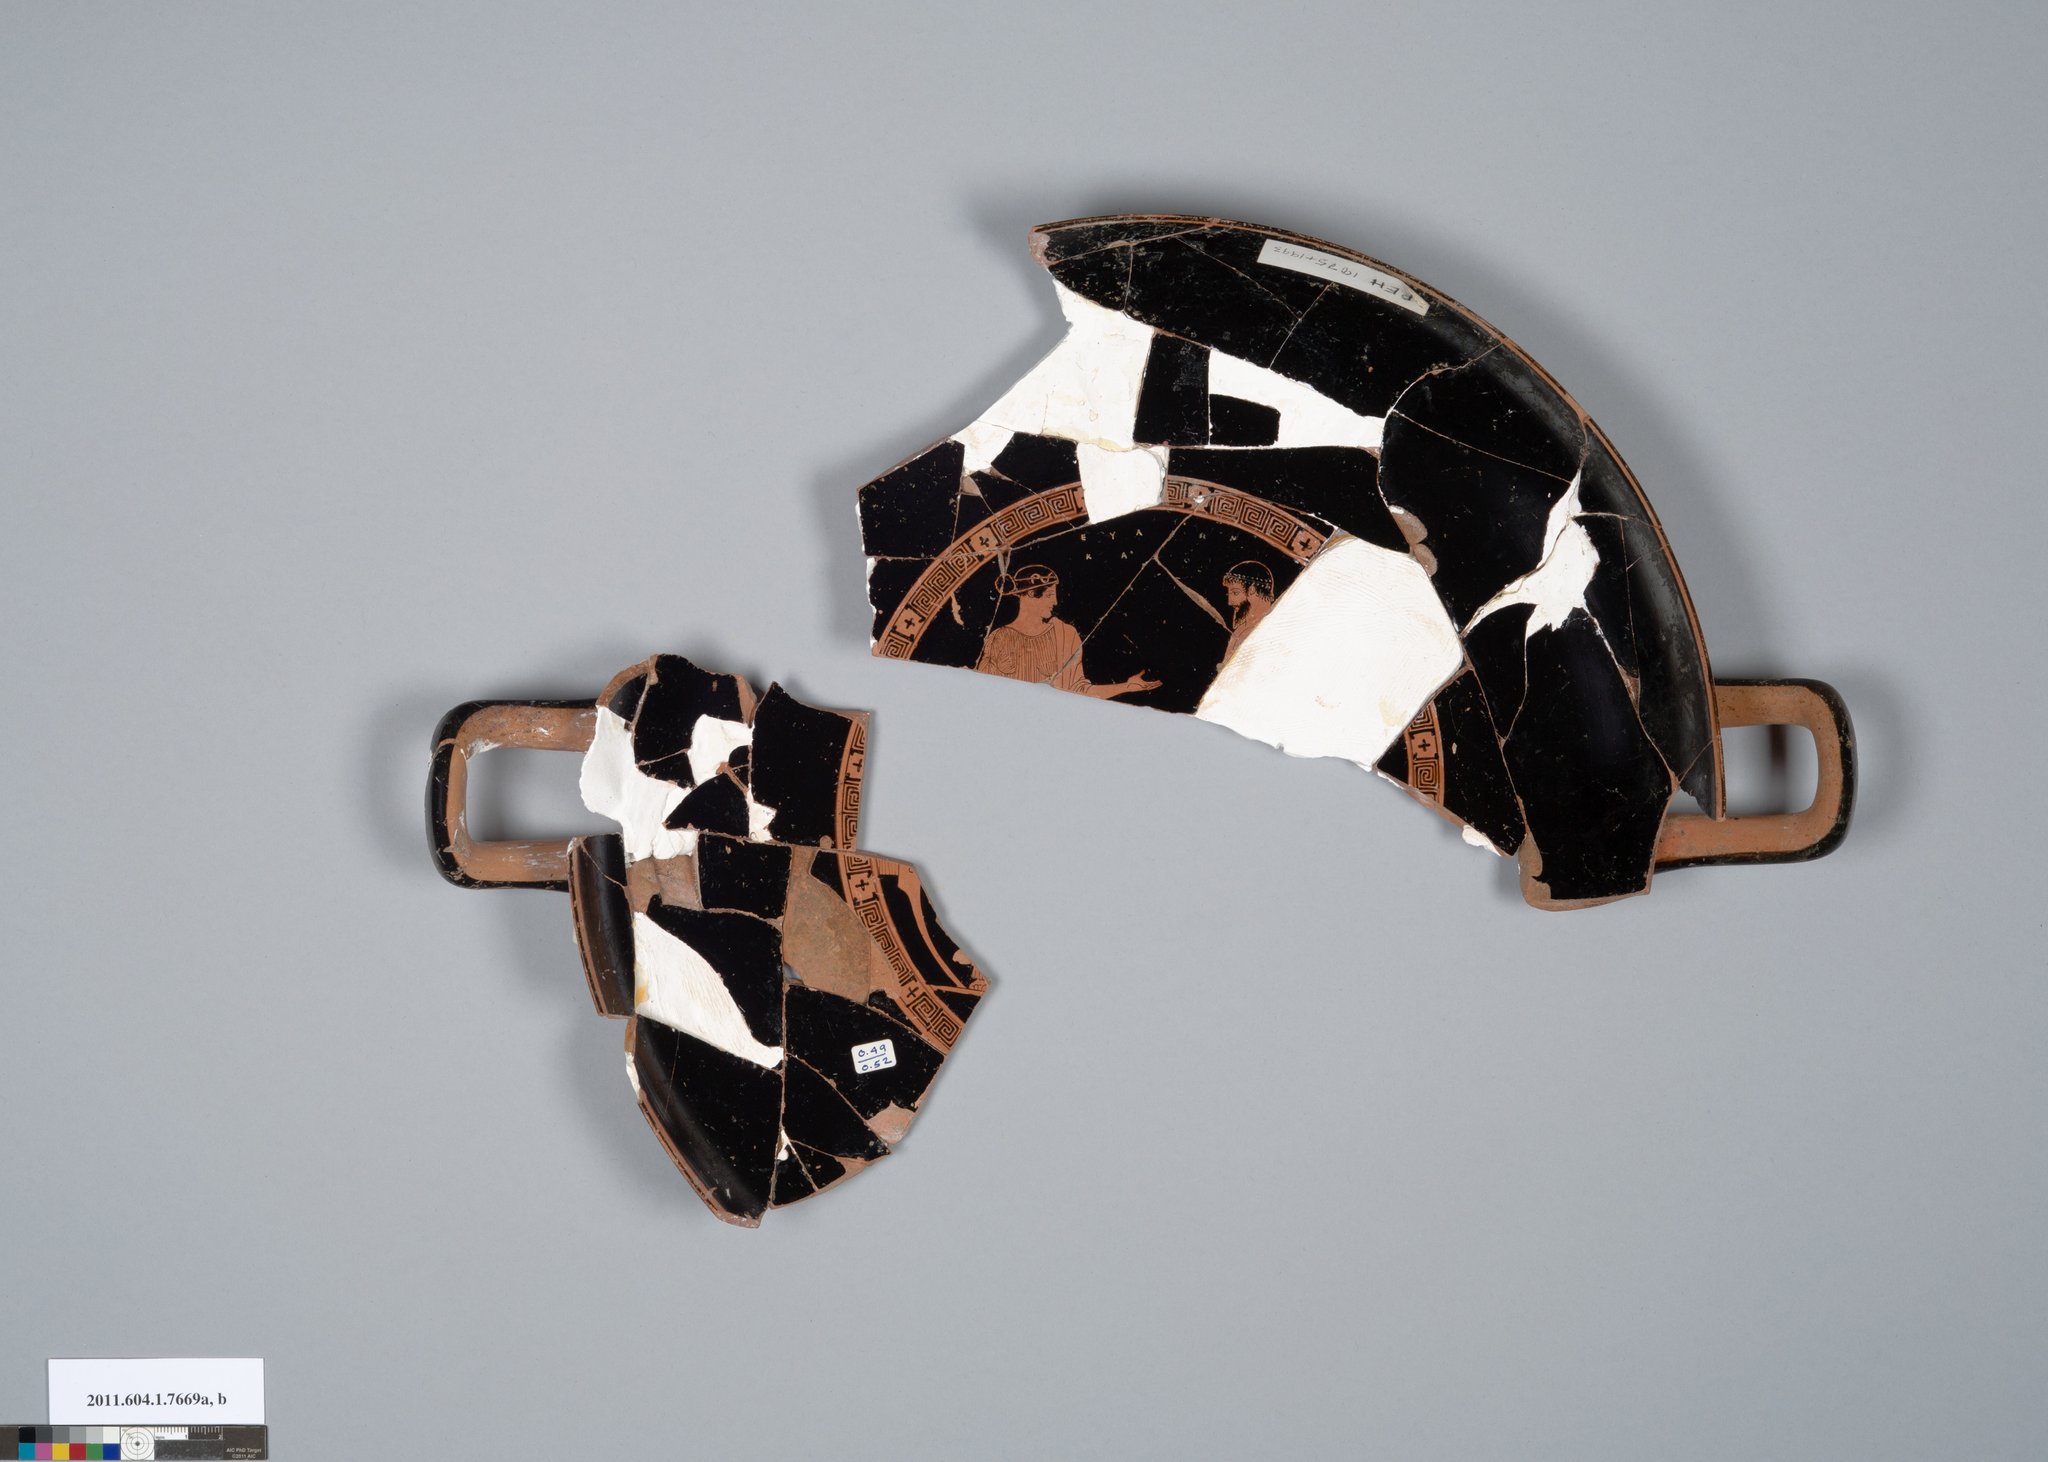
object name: kylix fragment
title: Terracotta fragments of a kylix (drinking cup)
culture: greek, attic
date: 460-450 BCE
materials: terracotta